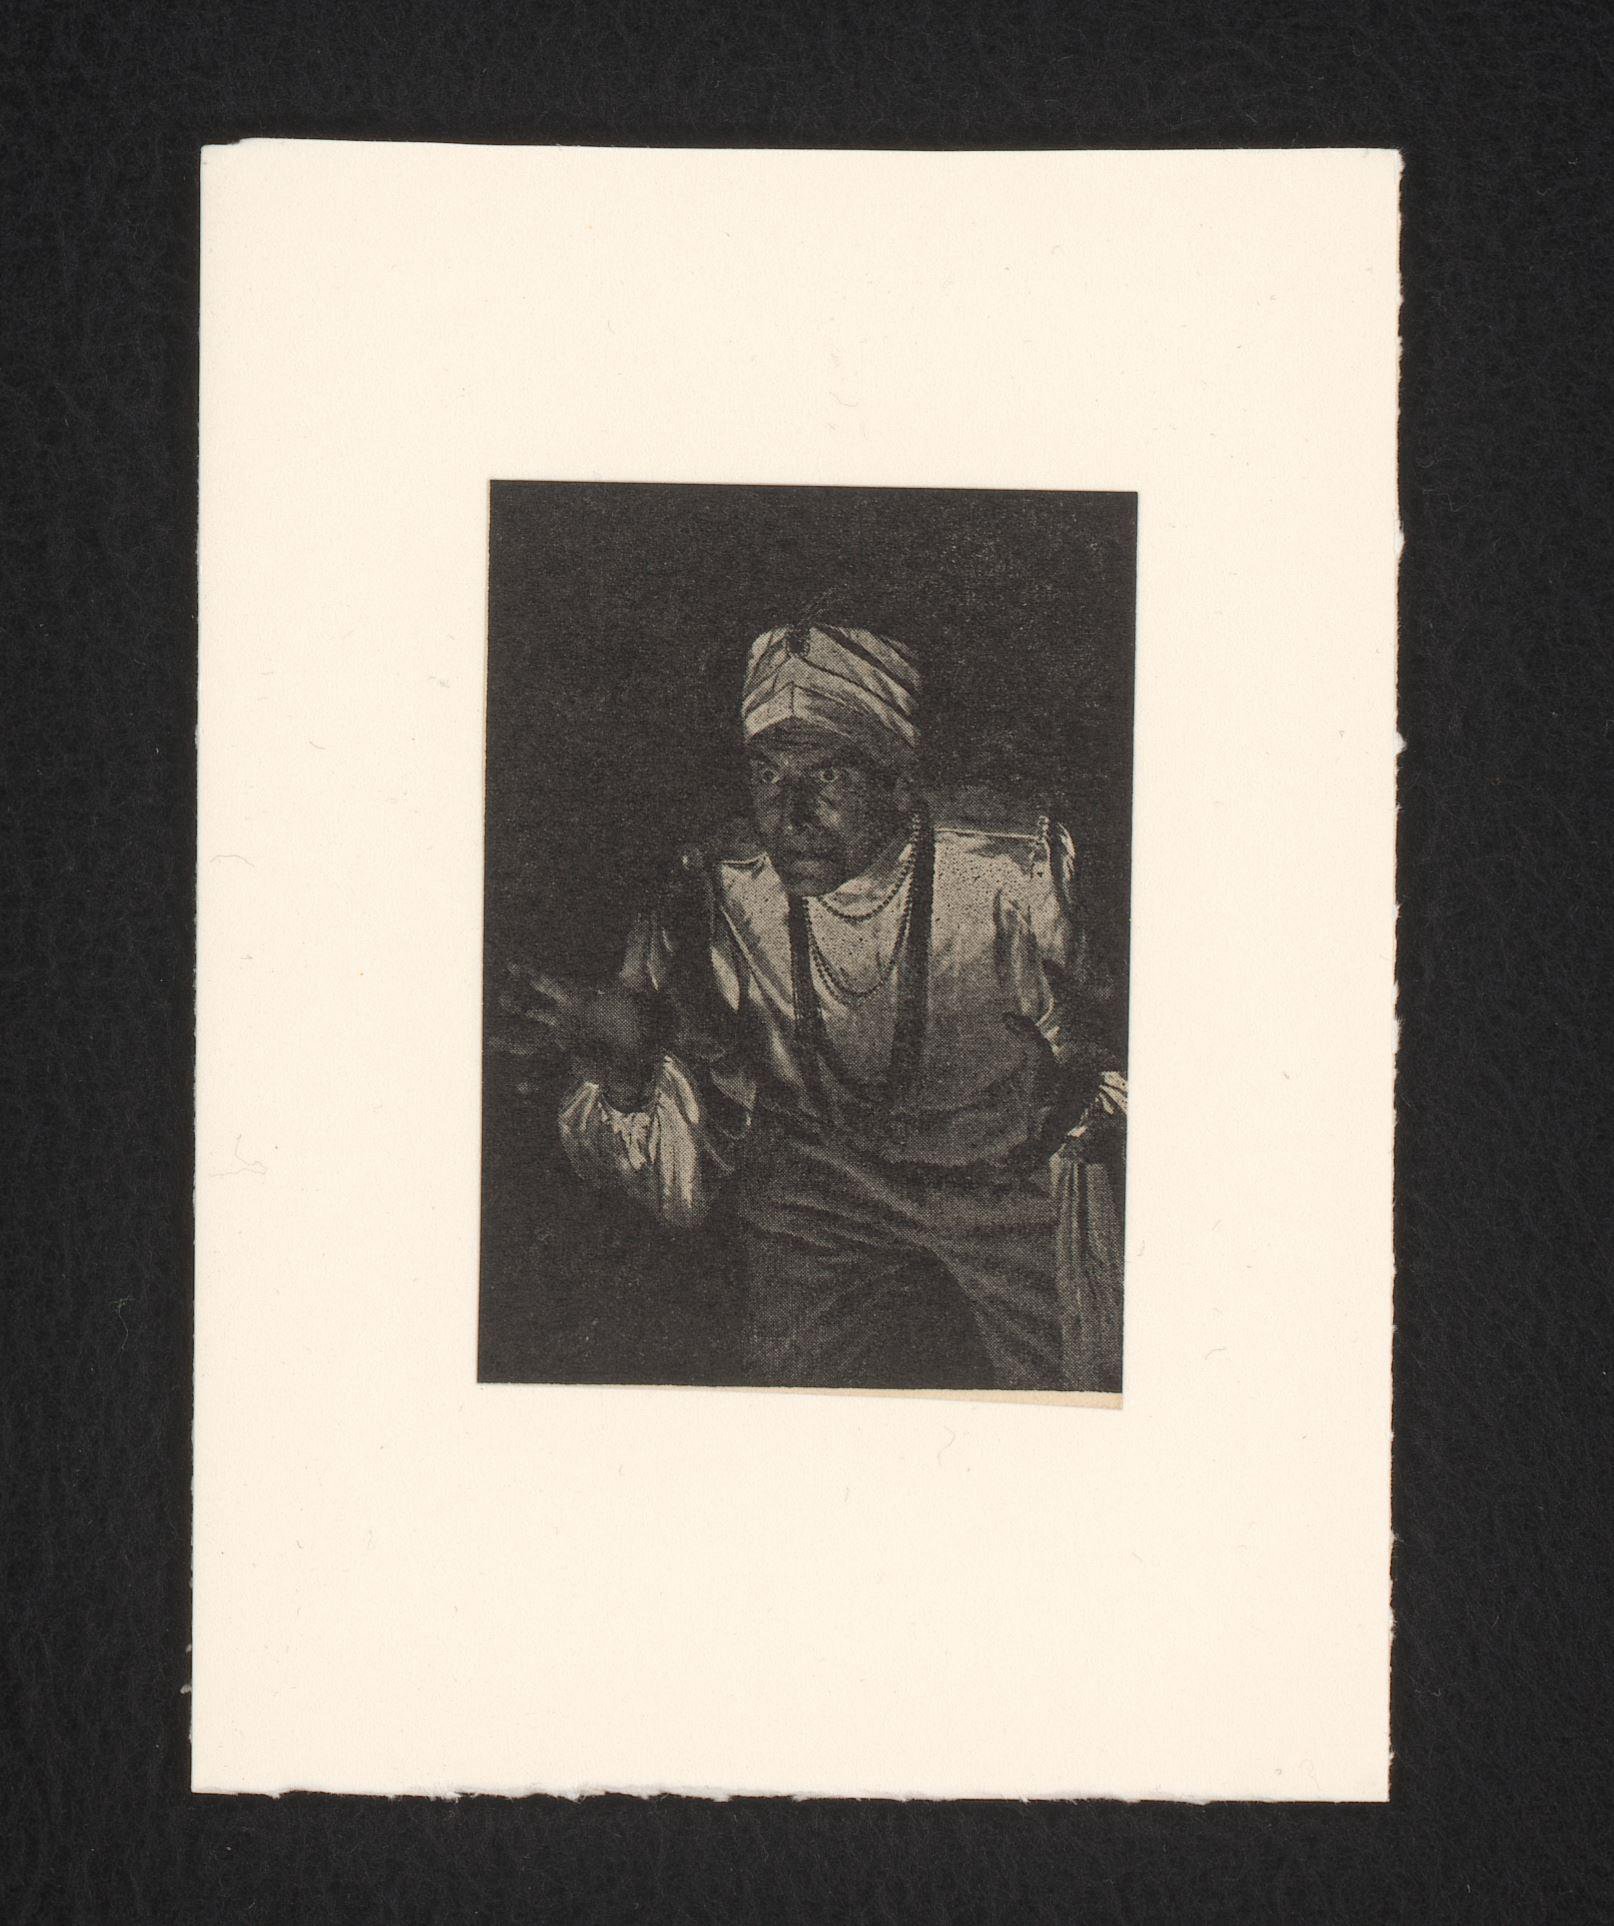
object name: photomechanical print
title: Portret van een man in een kostuum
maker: Anonymous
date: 1900-1950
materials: paper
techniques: albumen print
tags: stage costume, adult man, historical persons